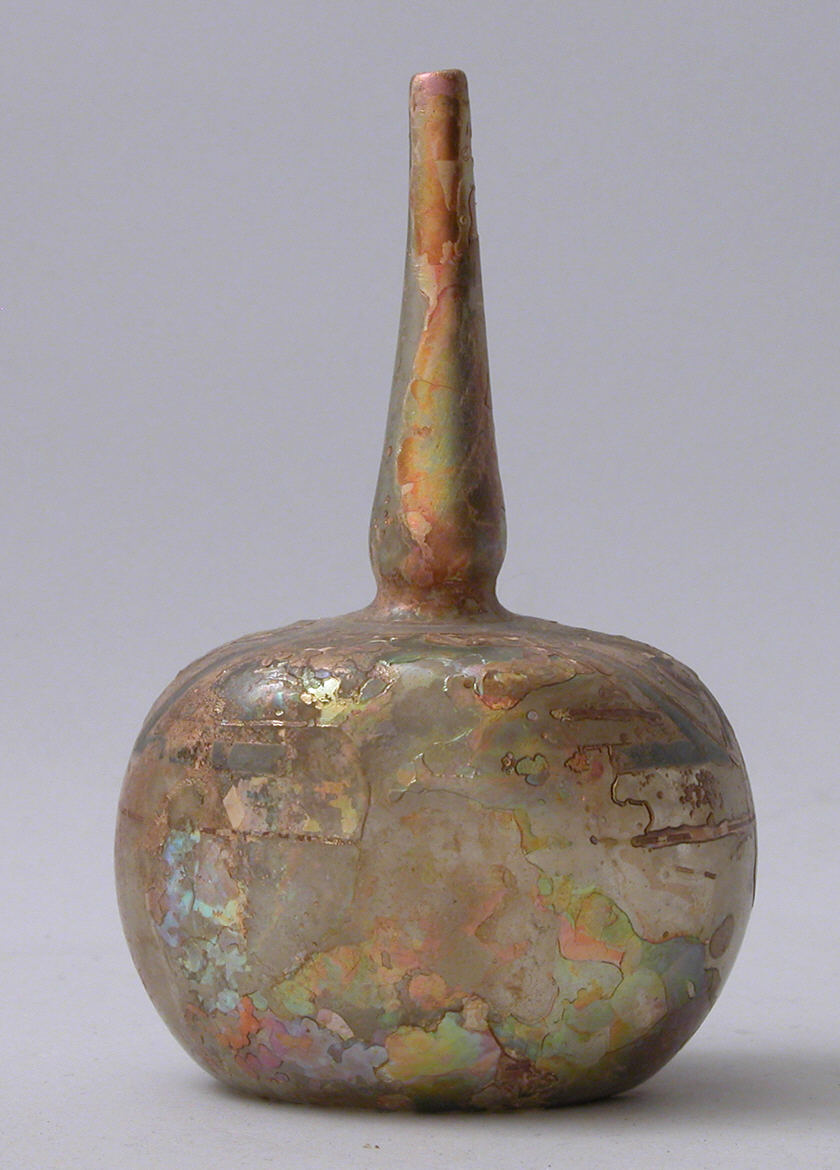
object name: bottle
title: Bottle (Qumqum)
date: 1201-1400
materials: glass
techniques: glassblowing, painting, tooling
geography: syria